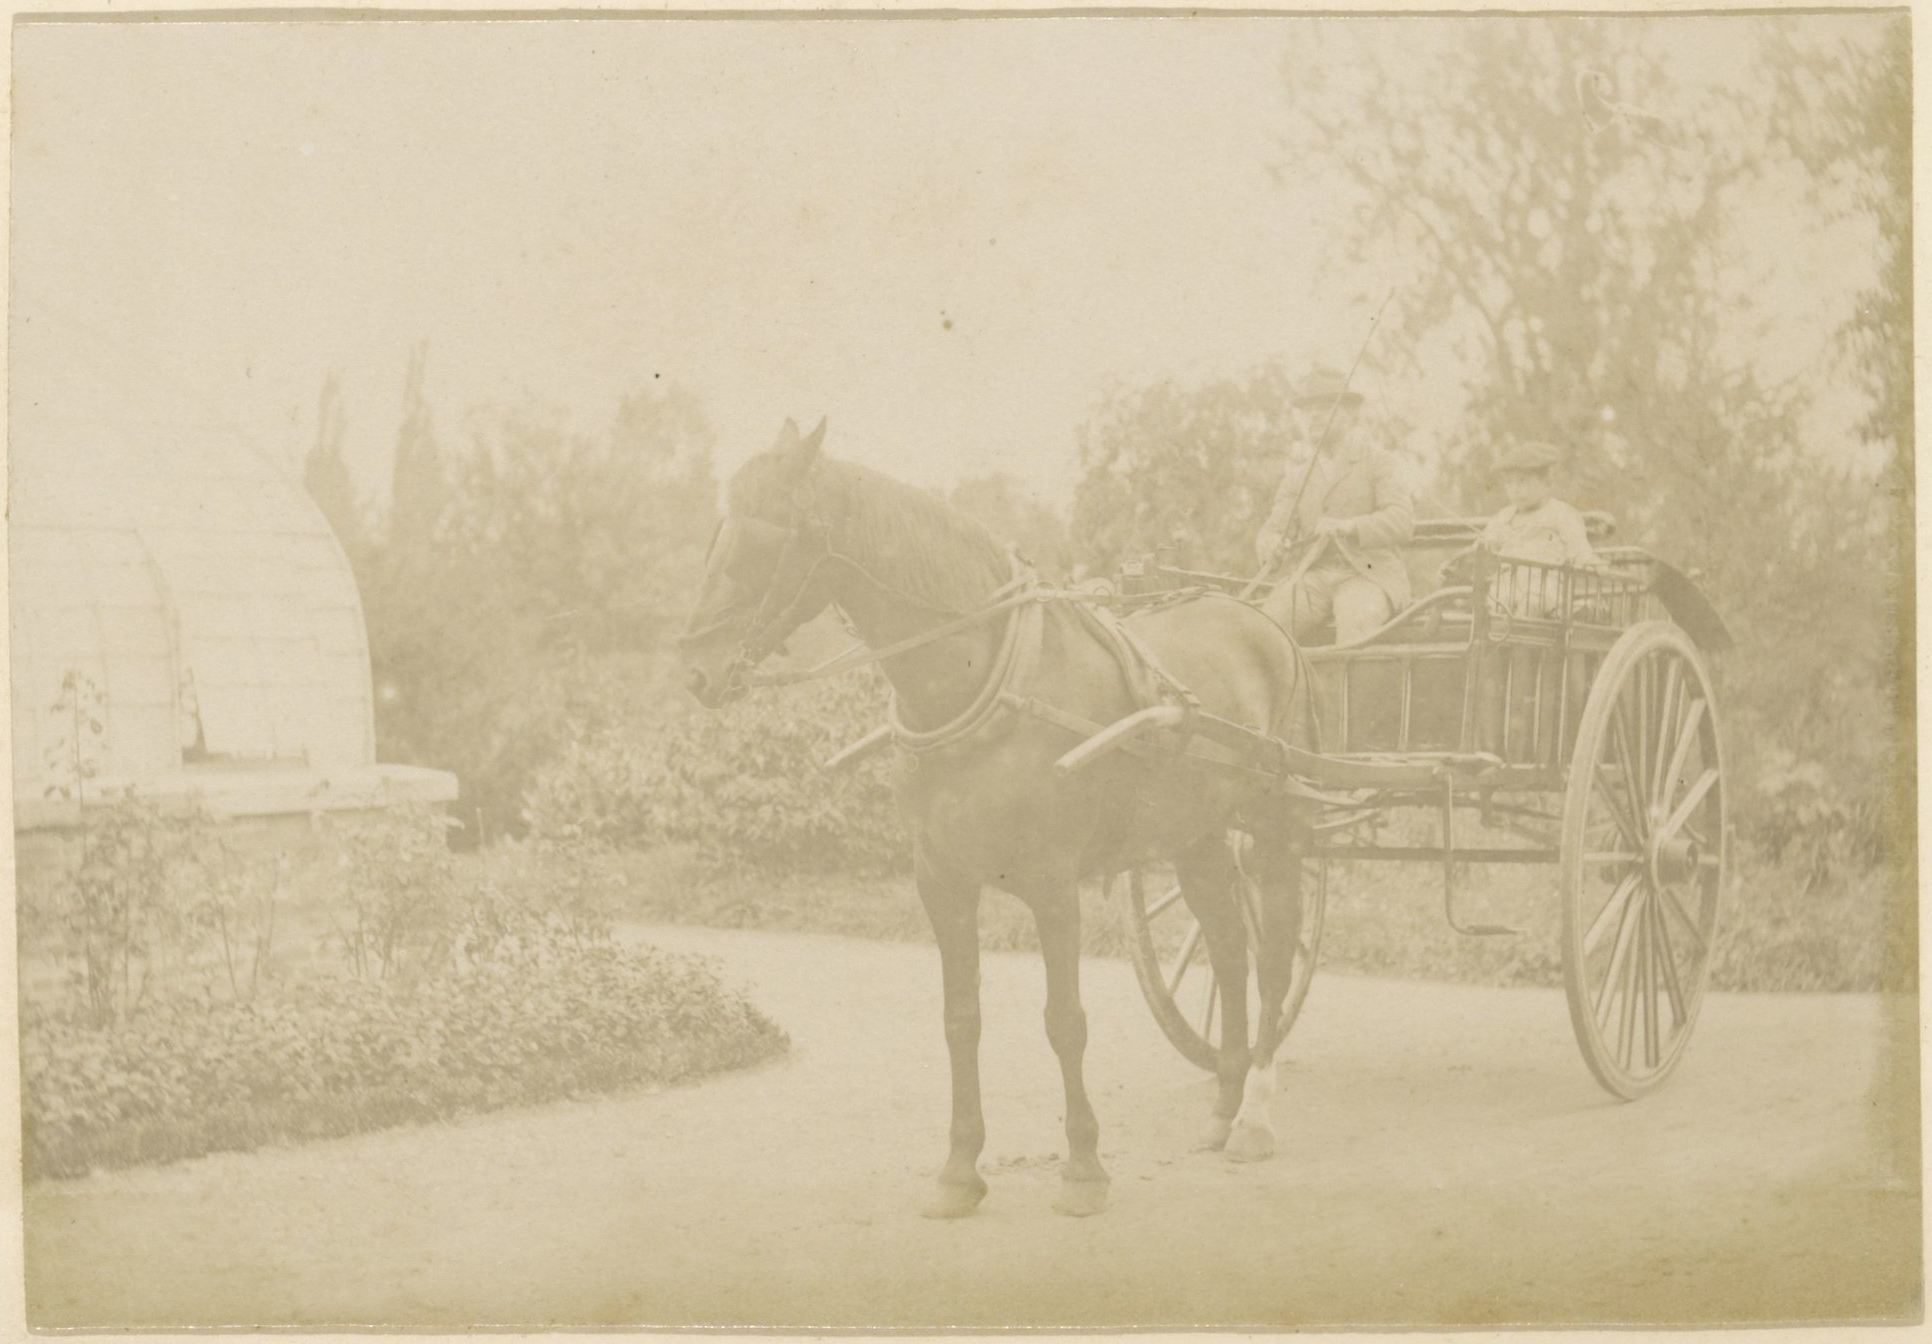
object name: photograph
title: Paardenkar met een man en een kind in een tuin in Frankrijk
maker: Anonymous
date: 1900-1910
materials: paper, photographic support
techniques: albumen print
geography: france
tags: two-wheeled, animal-drawn vehicle, adult man, france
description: Onderdeel van Fotoalbum van een Franse amateurfotograaf met opnames van een familie, distilleerderij Delizy & Doistau Fils, het leger en bezienswaardigheden in Frankrijk.